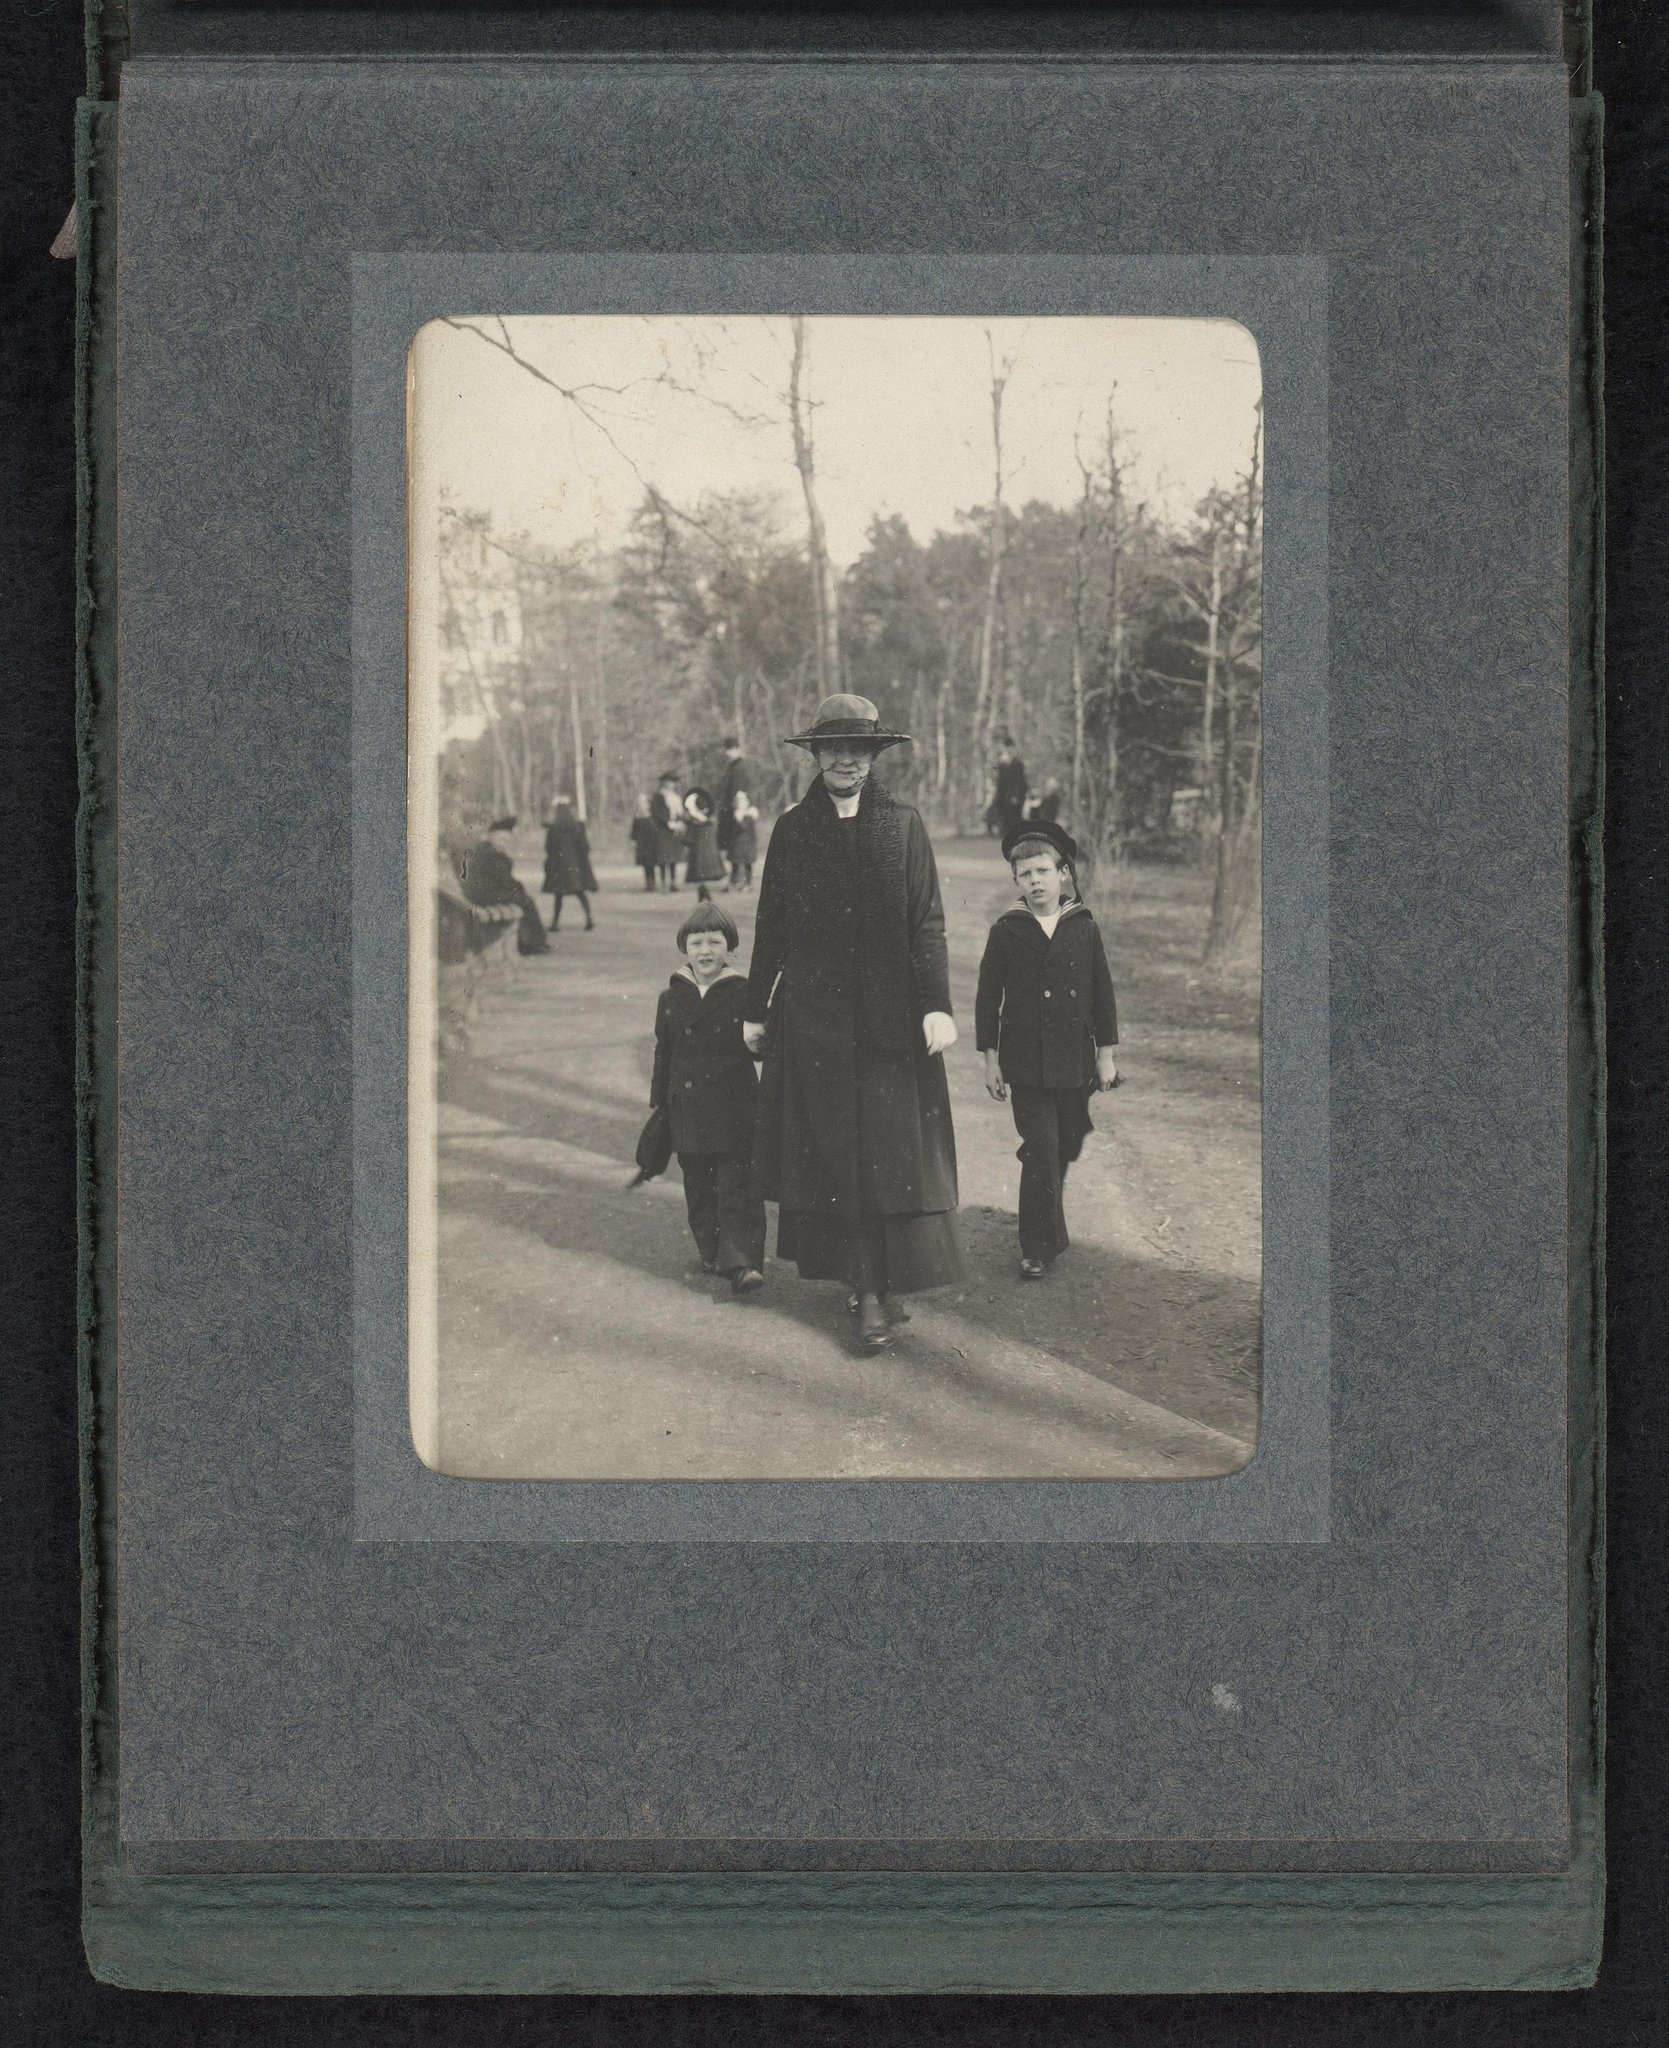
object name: photograph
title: Caroline, Carel en Frank van den Berg in een stadspark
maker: hendrik herman van den berg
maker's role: amateurfotograaf, jurist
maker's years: 1875-1944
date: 1918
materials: paper, cardboard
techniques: gelatin silver print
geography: amsterdam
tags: the hague, caroline louise van den berg-van den berg, carel frederik van den berg (cay), frank willem van den berg (1912-1998), mother and son(s) (family group), park